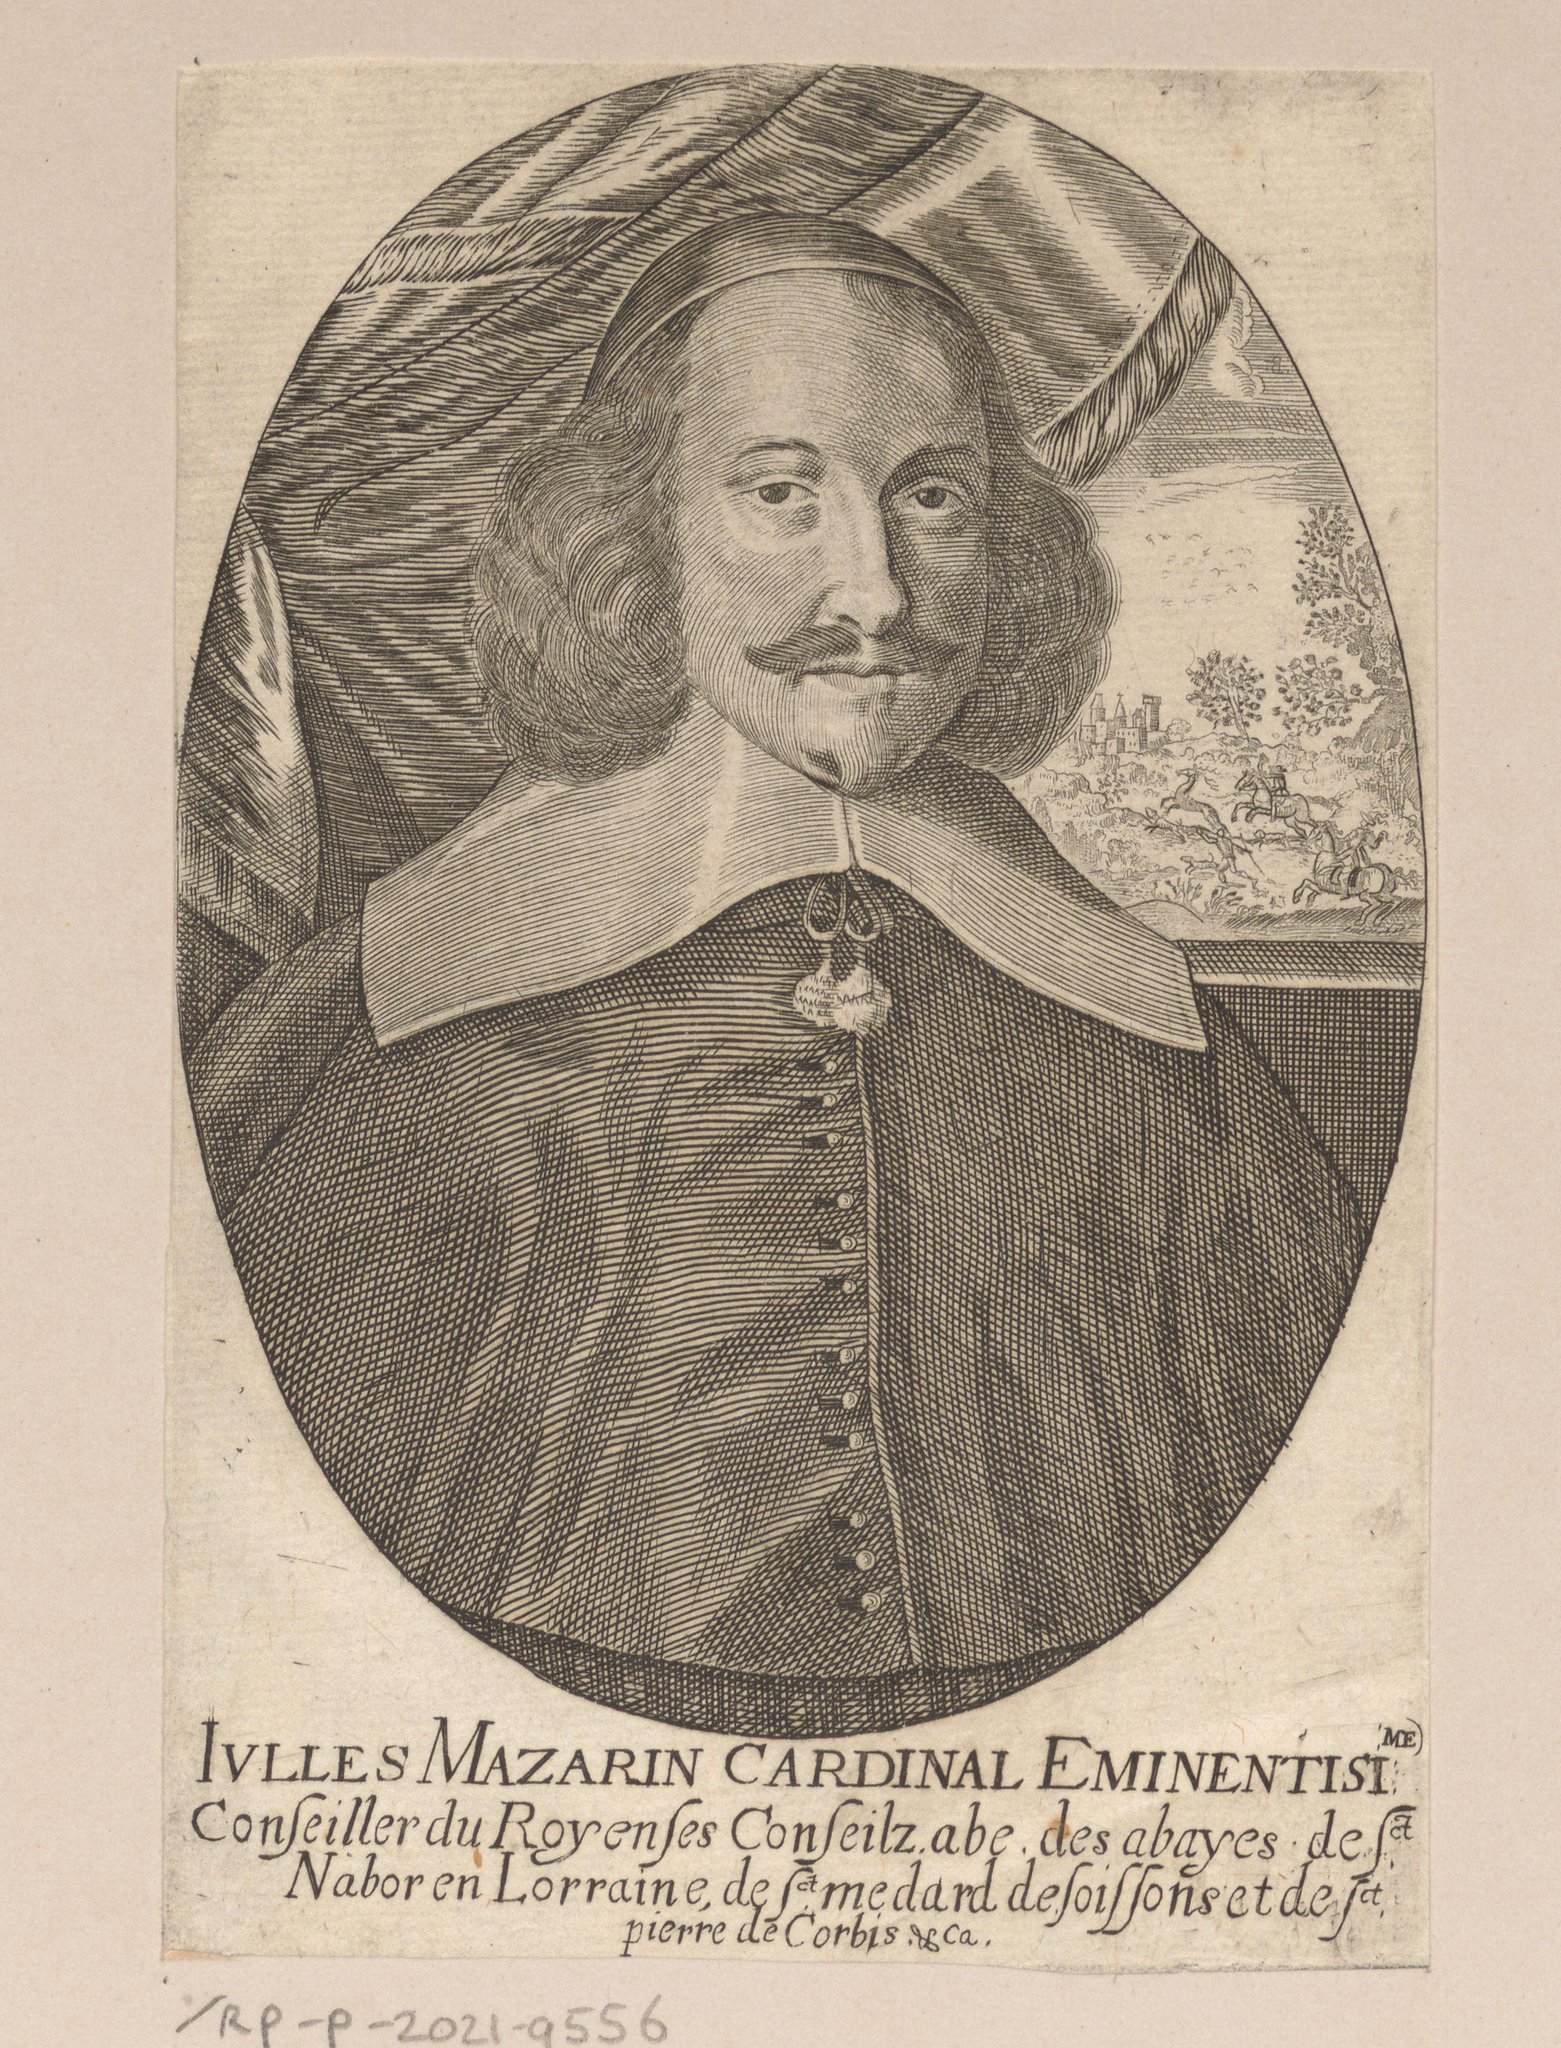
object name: print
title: Portret van Jules Mazarin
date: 1647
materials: paper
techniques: engraving, etching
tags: jules mazarin, cardinal, historical persons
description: Prent met omlijsting en tekst in boekdruk gebruikt in: Abelin, Johann Philipp. Theatrum Europaeum (...). Frankfurt am Main: Matthaus Merian, 1647, dl. 5.